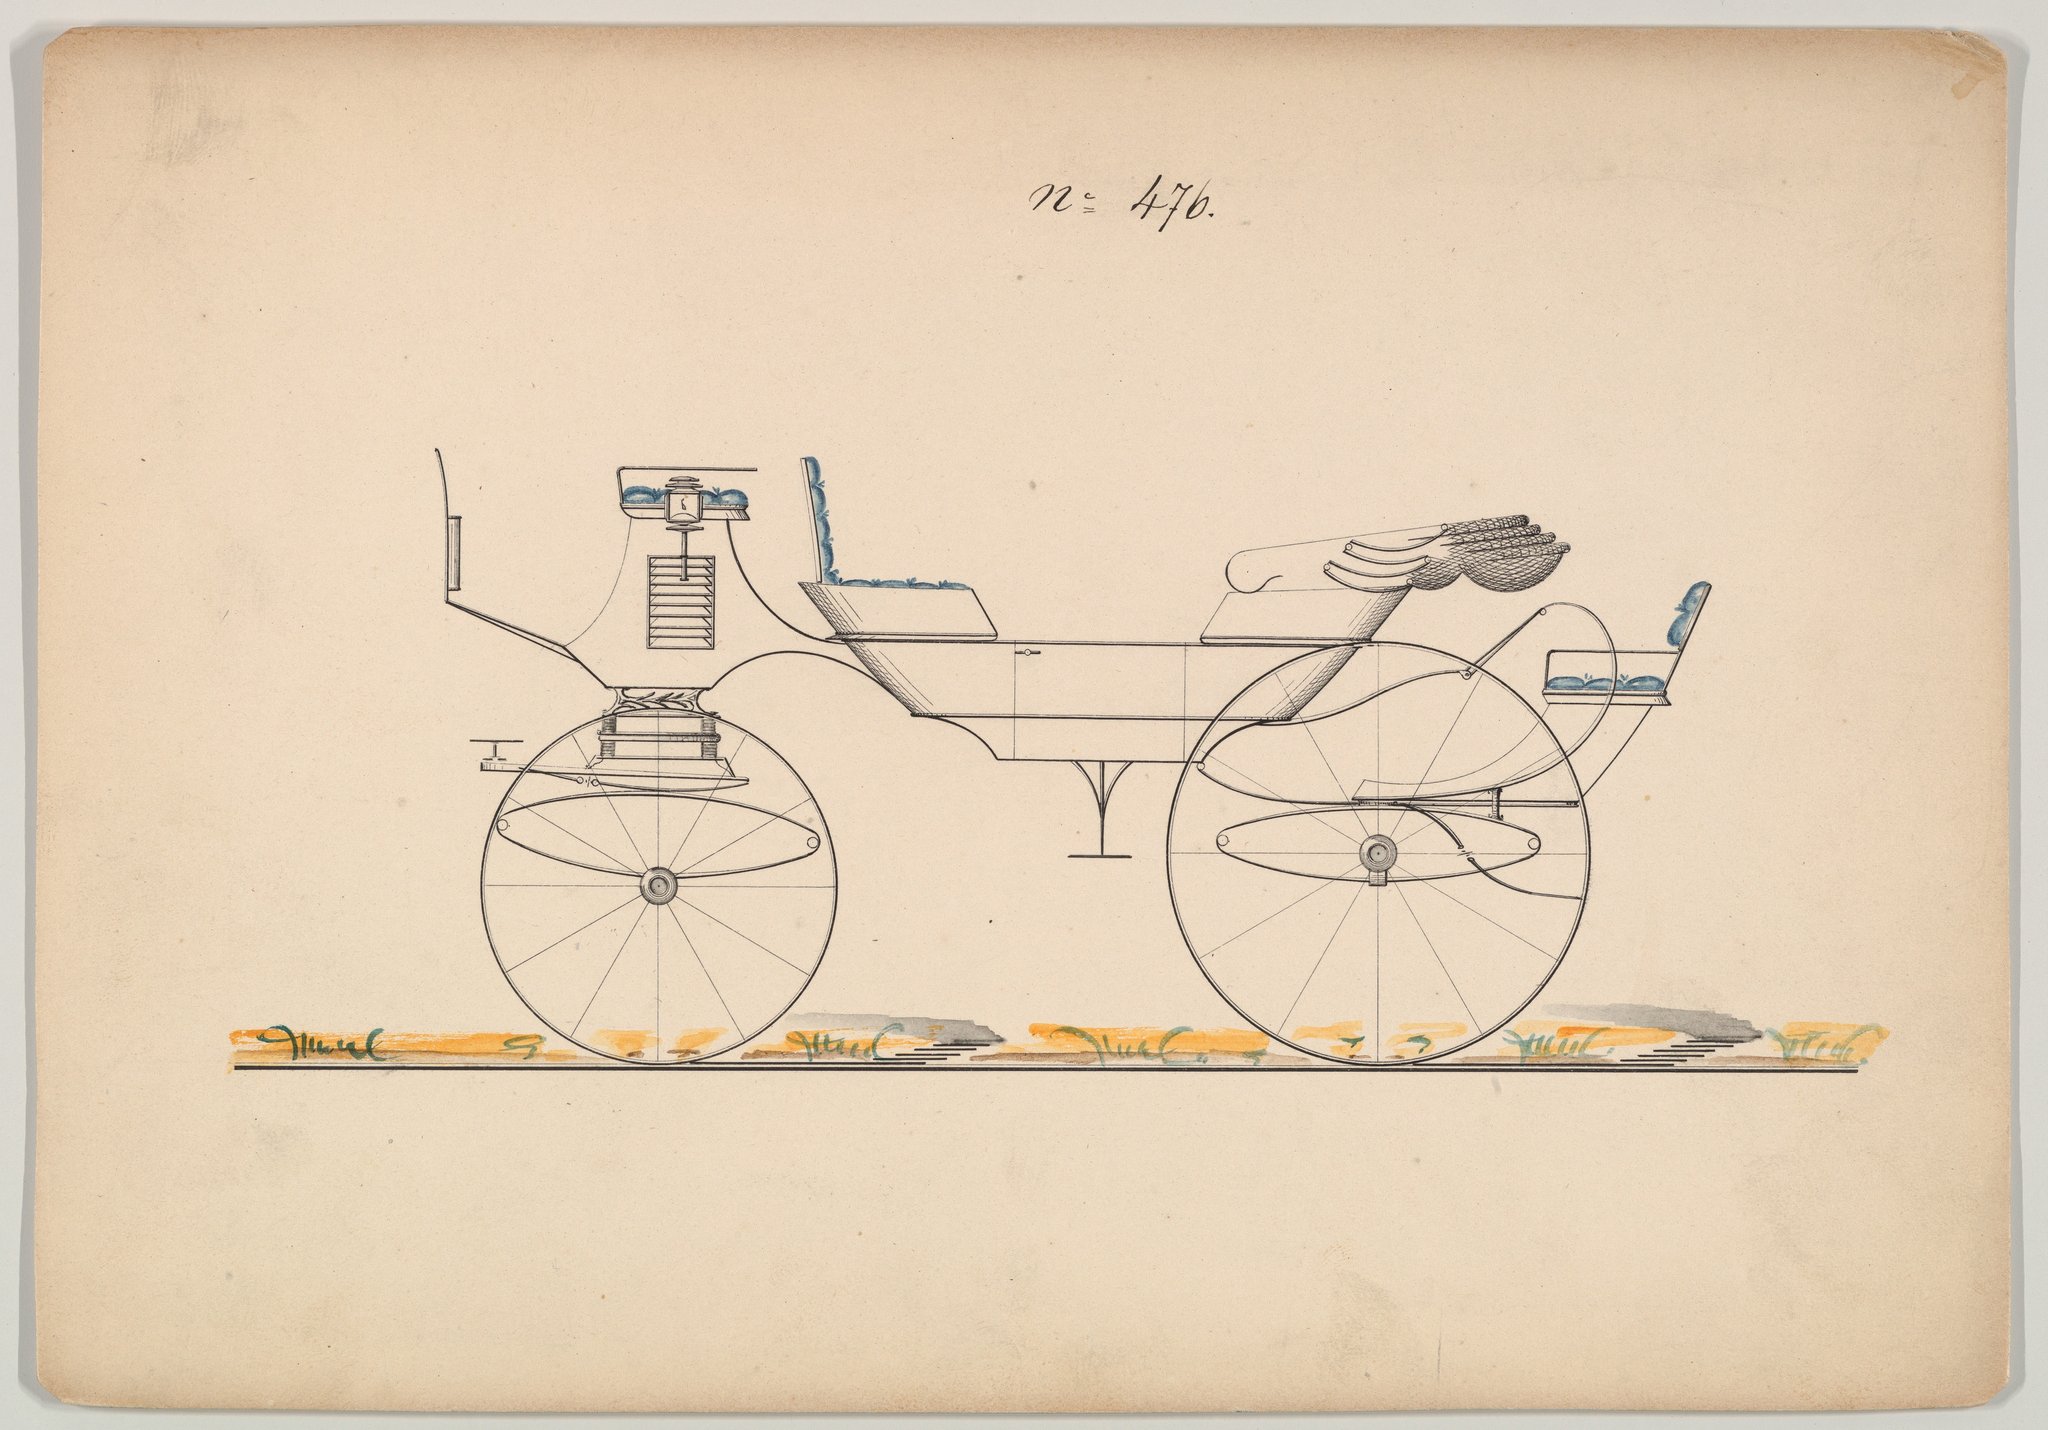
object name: drawing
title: Design for Vis-à-vis, no. 476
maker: brewster & co.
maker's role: manufacturer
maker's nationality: american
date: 1870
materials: gouache, ink, watercolor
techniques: pen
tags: carriages